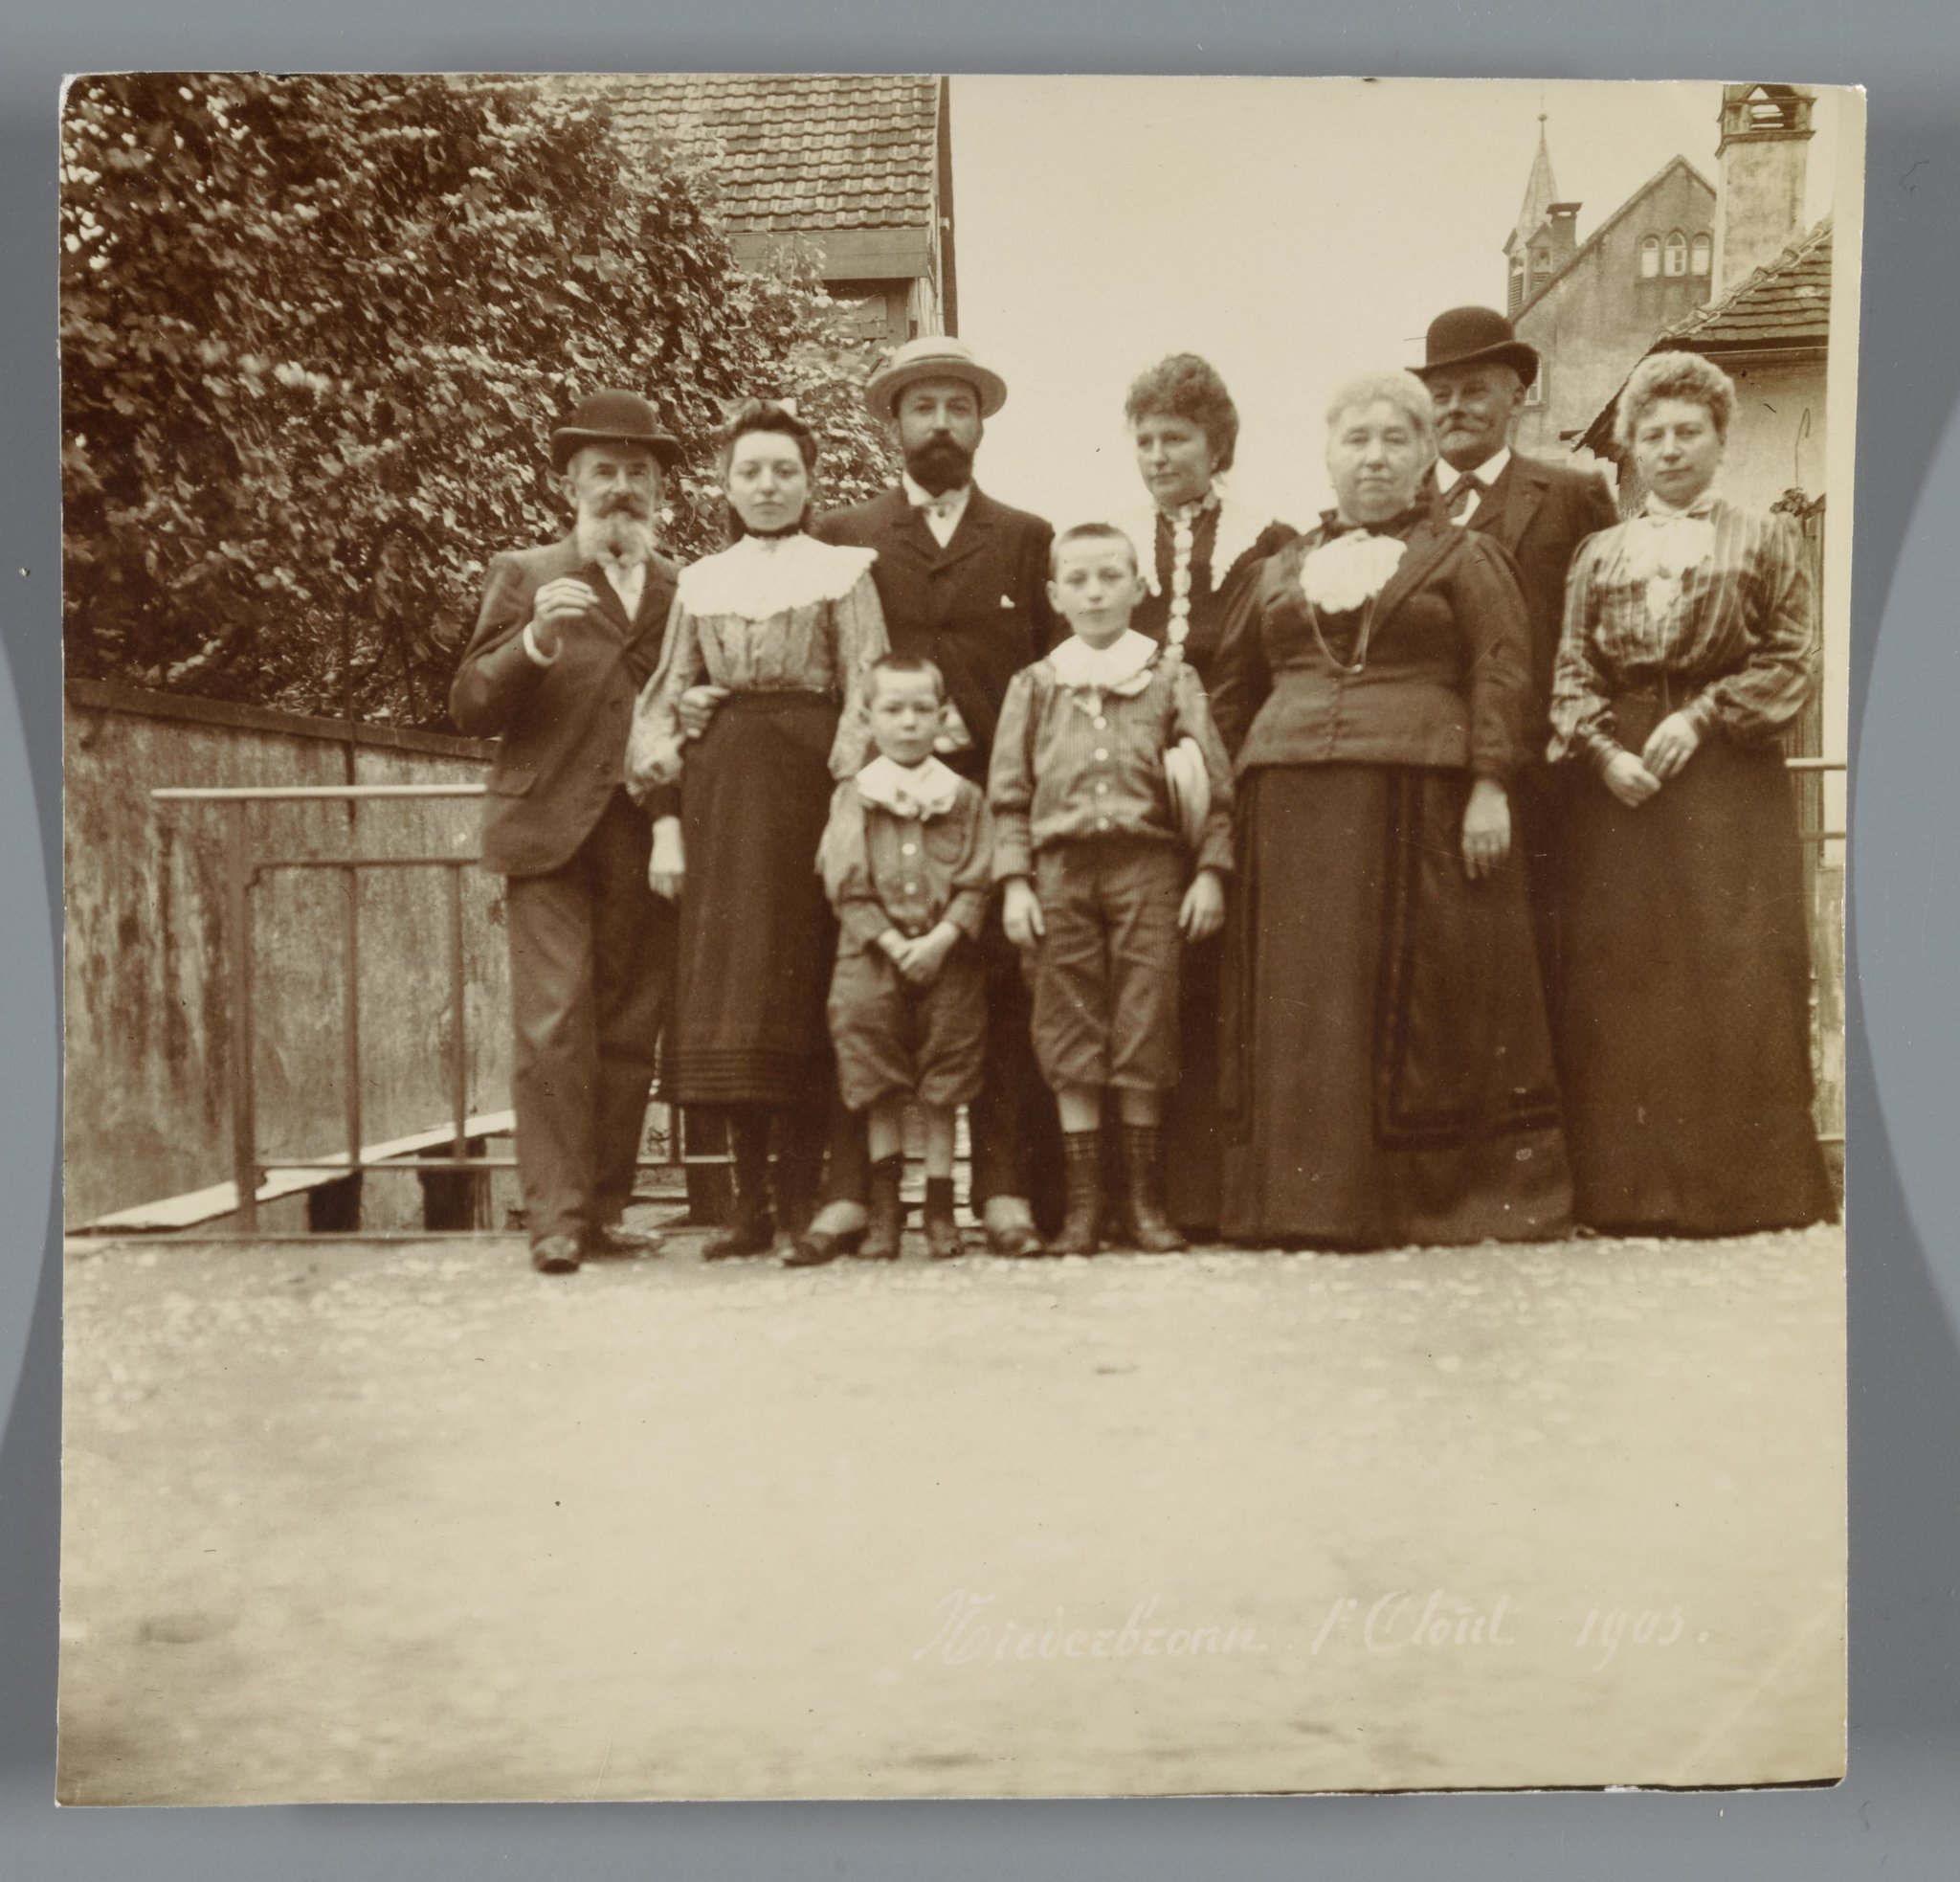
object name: photograph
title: Portraits of the Inhabitants of the Villages of Reichshoffen, Niederbronn, and Jaegerthal, Alsace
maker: Anonymous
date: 1903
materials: paper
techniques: gelatin silver print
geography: france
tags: public road in village (+ city(-scape) with figures, staffage), france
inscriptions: annotation: ‘Niederbronn 1 Août 1903’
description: Groepsportret van drie mannen, vier vrouwen en twee kinderen, Niederbronn (Bas-Rhin), Frankrijk.